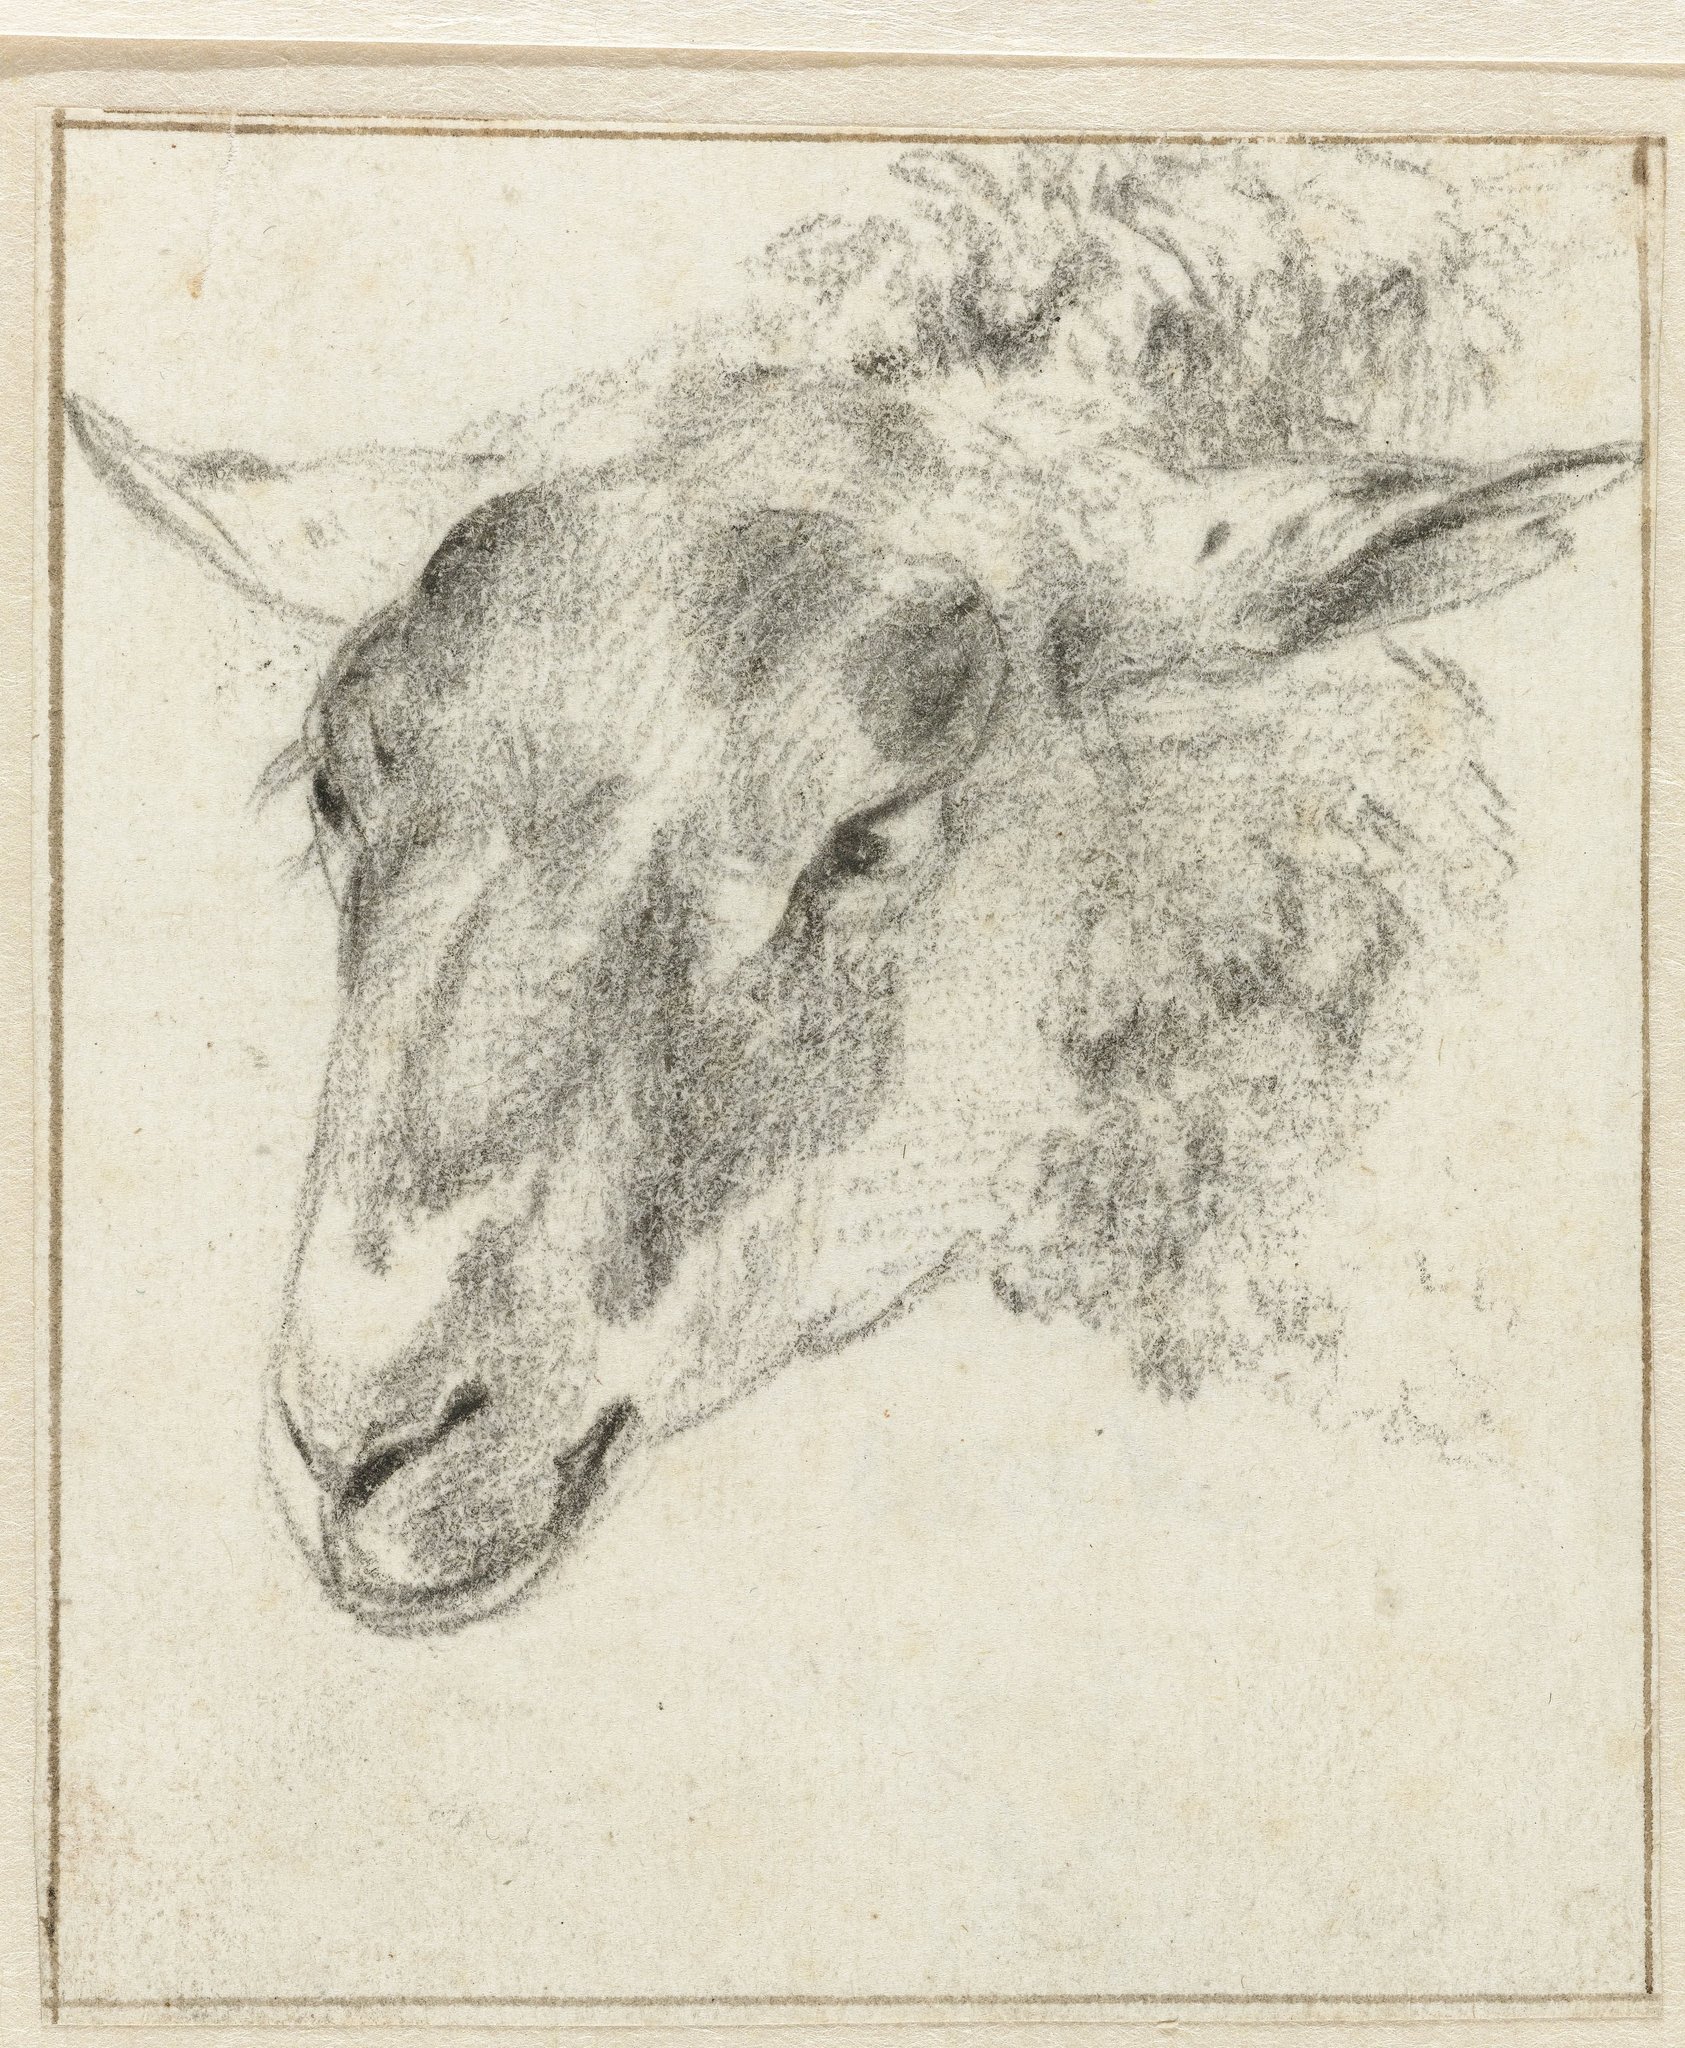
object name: drawing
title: Schapenkop, iets van boven en van opzij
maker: adriaen van de velde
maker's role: draughtsman, painter, print maker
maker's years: 1636-1672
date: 1646-1672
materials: chalk, paper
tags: sheep (+ head of an animal)